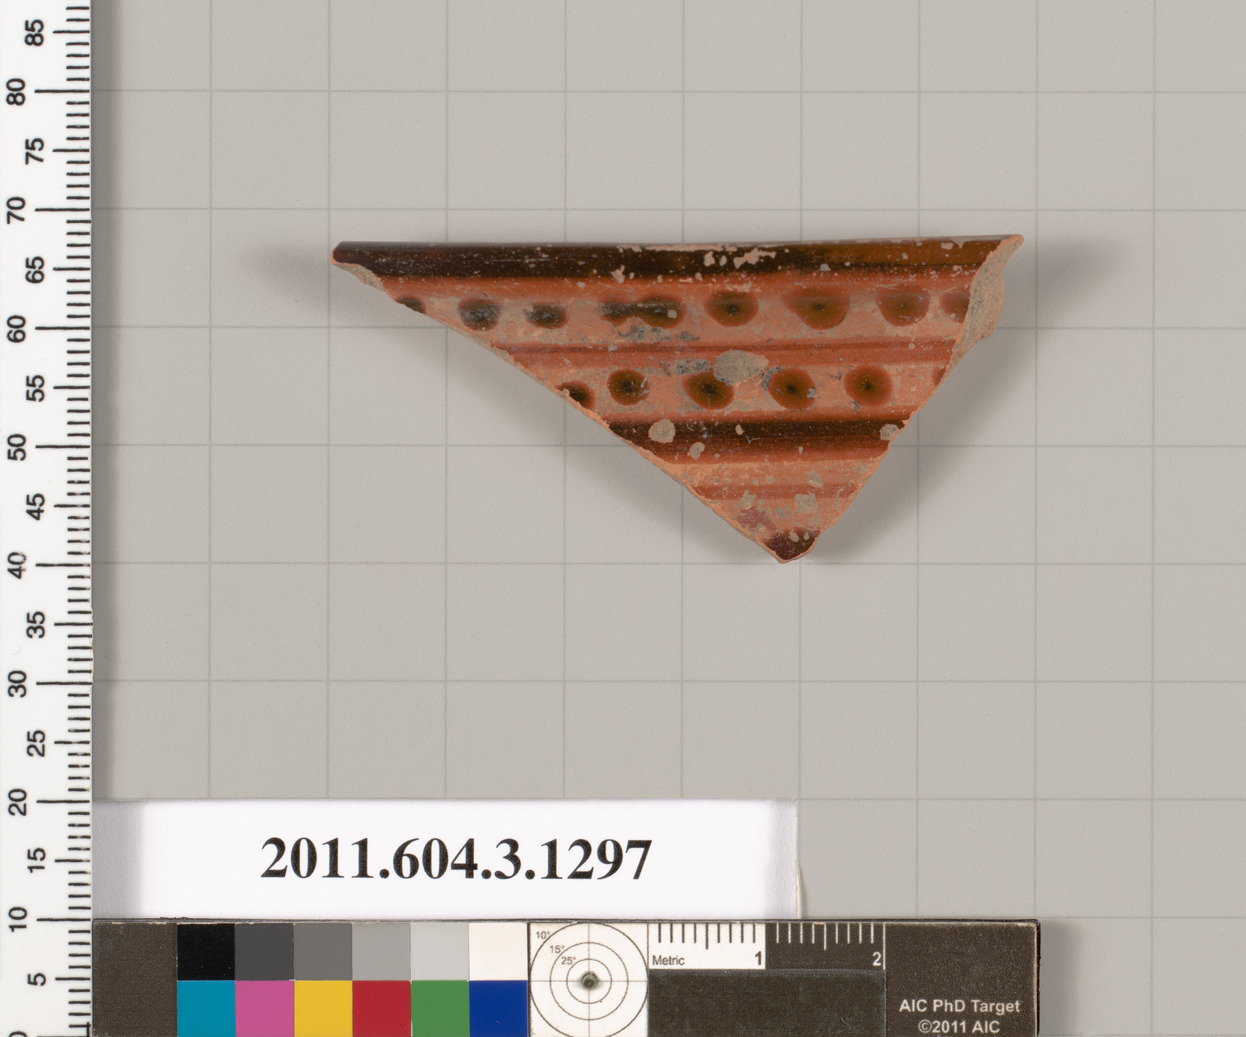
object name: skyphos fragment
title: Terracotta rim fragment of a skyphos (deep drinking cup)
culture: greek, attic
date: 500 BCE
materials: terracotta